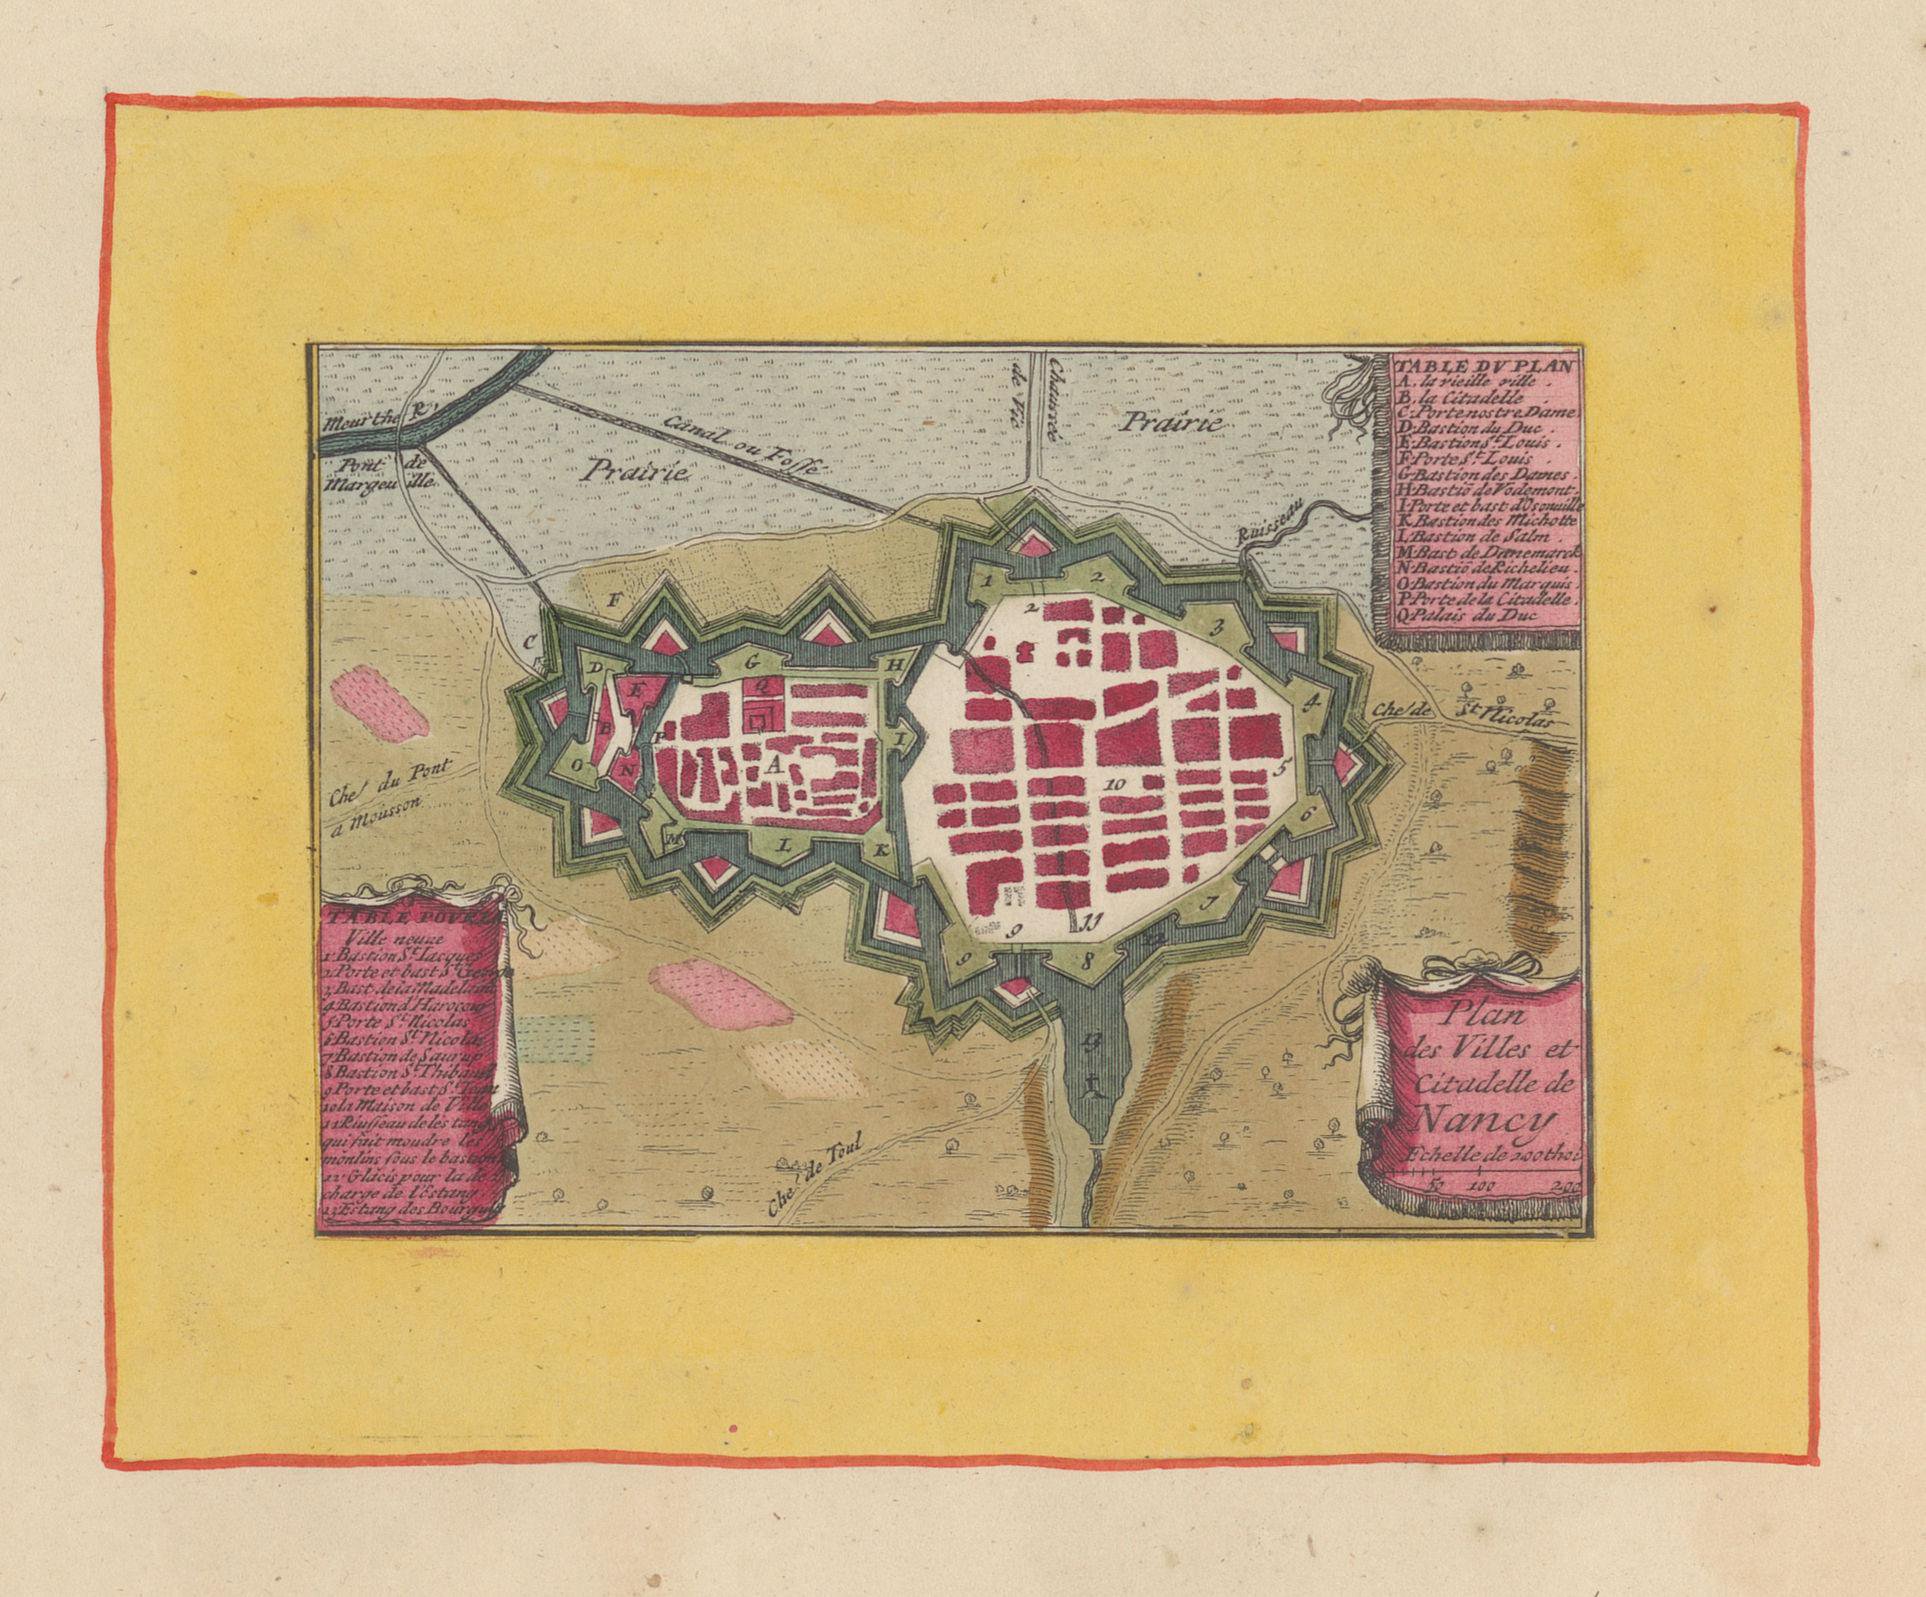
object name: area plan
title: Nanci, ville forte et la plus considerable du duché de Lorraine (...)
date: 1690-1695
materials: paper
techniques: engraving, hand coloring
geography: paris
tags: maps of cities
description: Prent uit: Les forces de l'Europe. Parijs: Nicolas de Fer, 1690-1695.